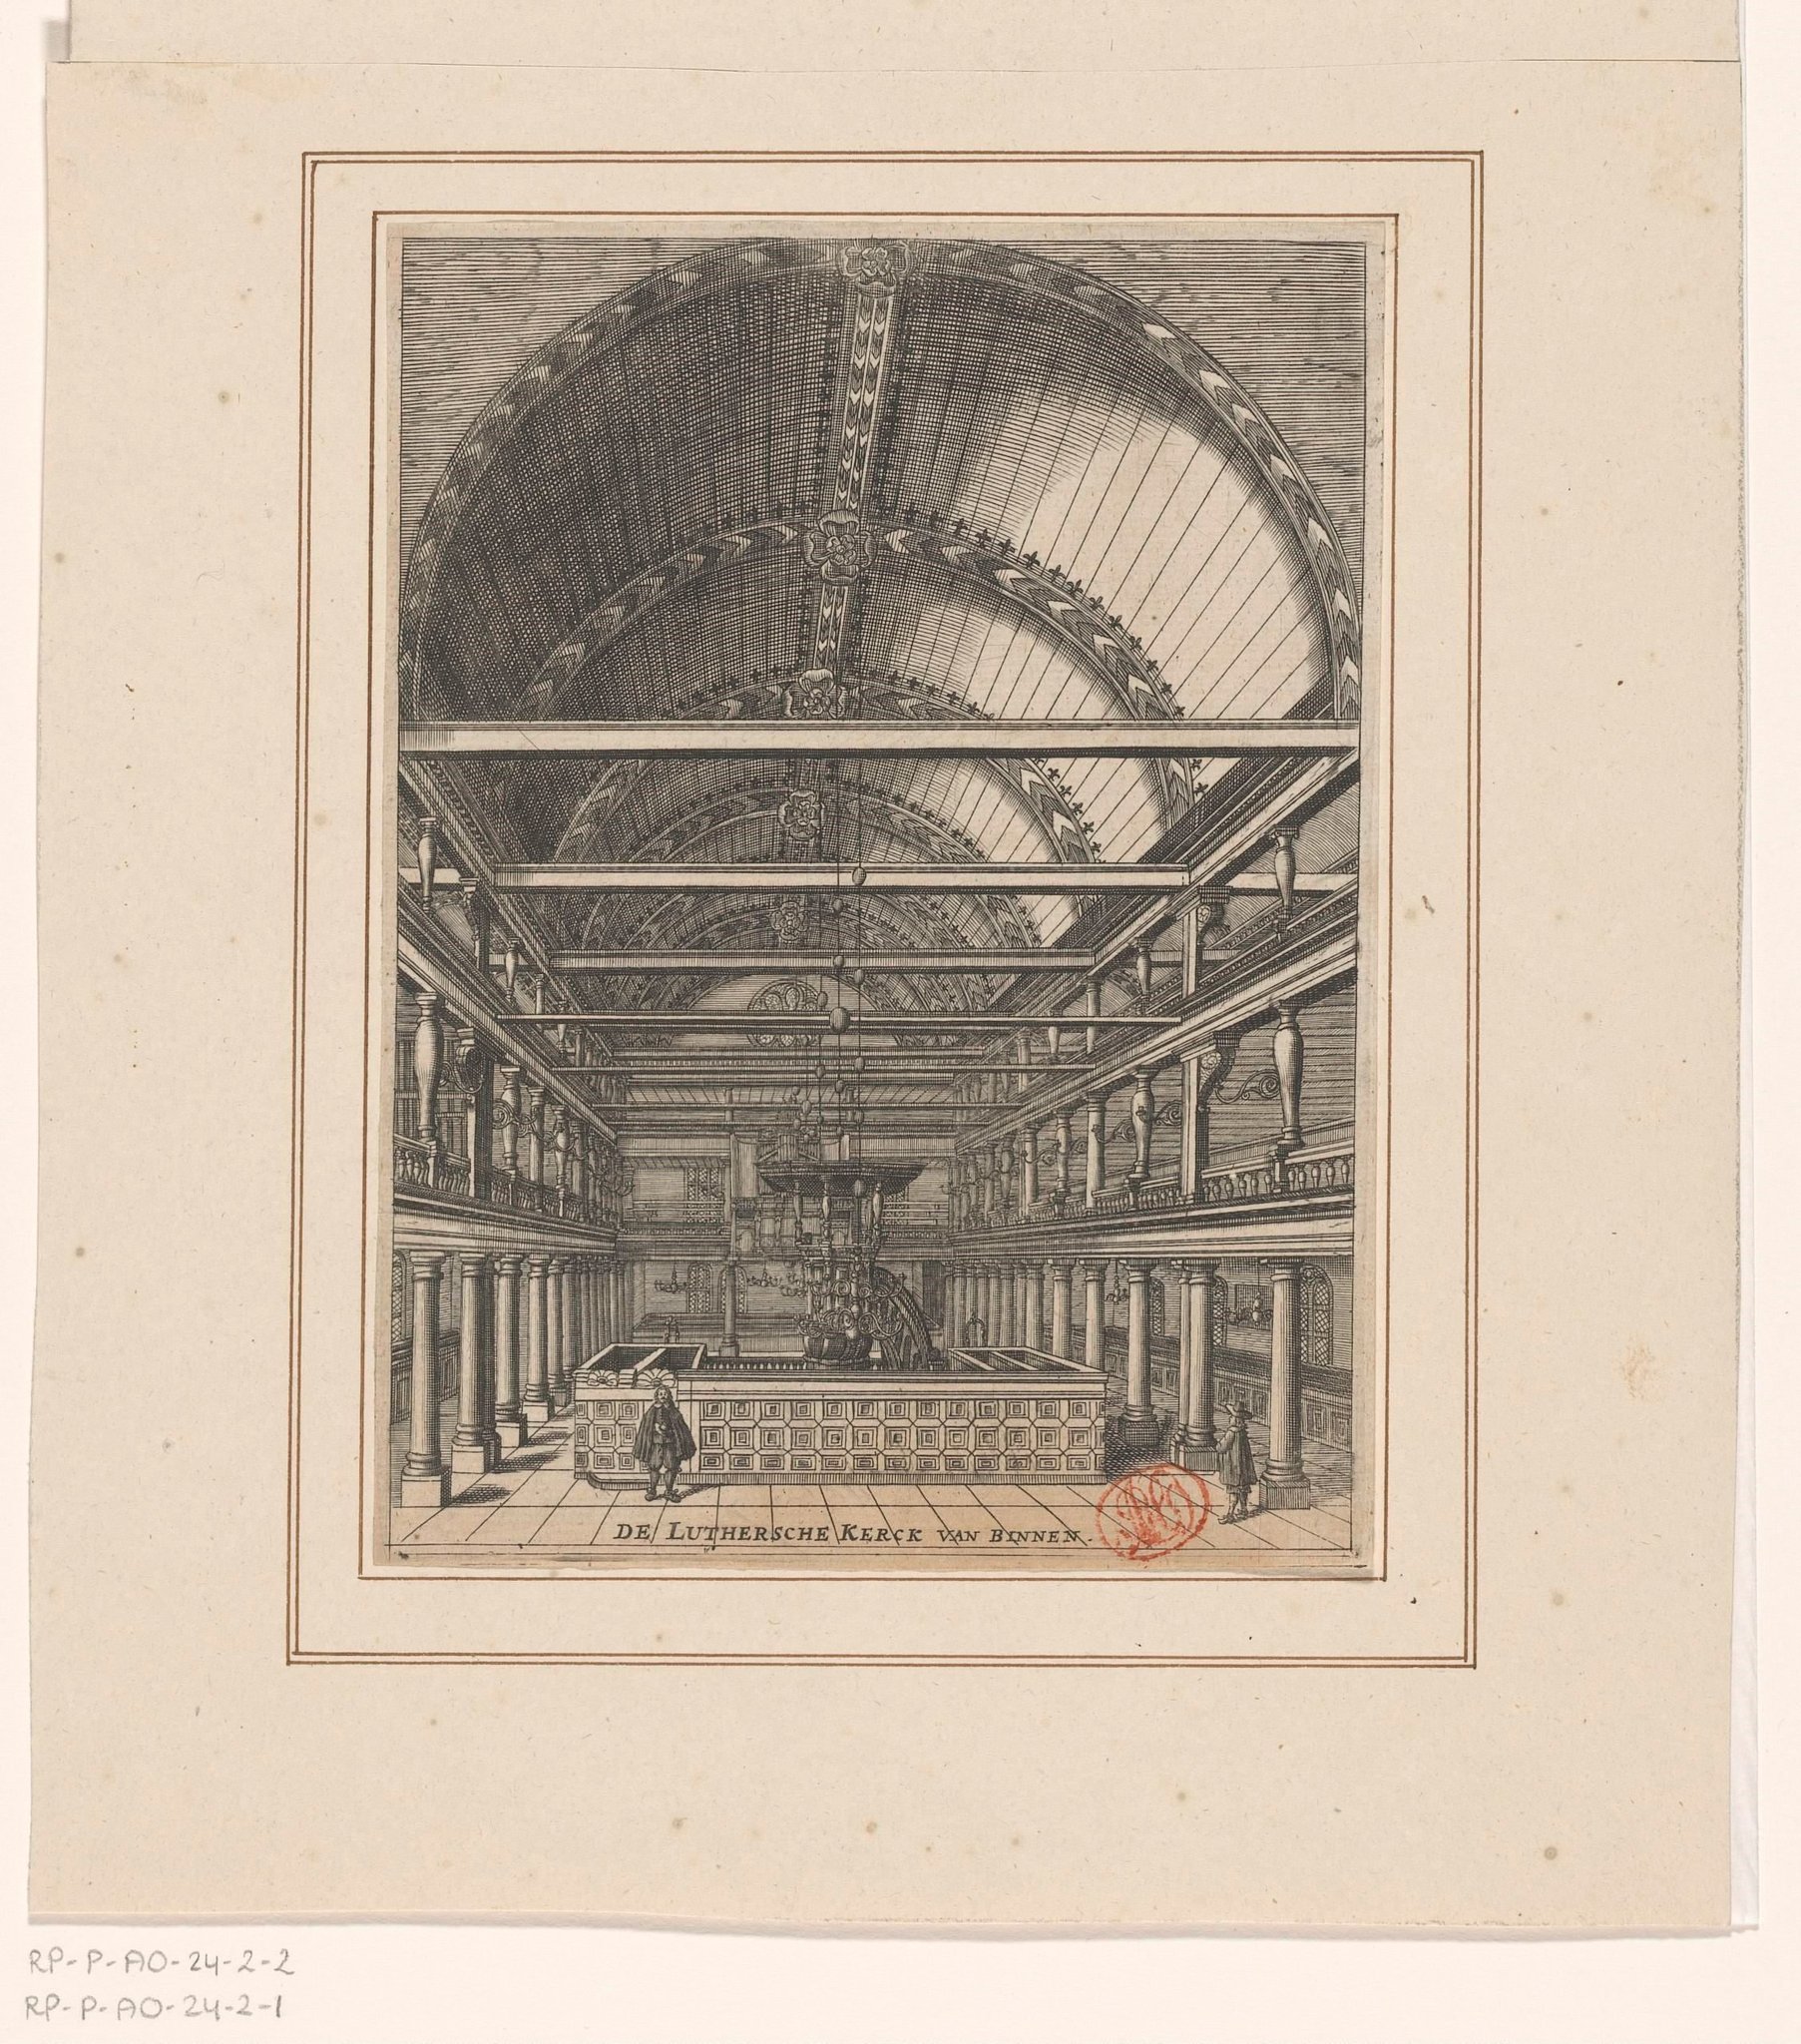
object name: book illustration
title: Interieur van de Oude Lutherse Kerk te Amsterdam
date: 1664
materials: paper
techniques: engraving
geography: amsterdam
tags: protestant churches and denominations (lutherans), interior of church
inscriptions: collector's mark: Lugt 195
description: Prent ook gebruikt in: Zesen, Philipp von. Beschreibung der Stadt Amsterdam: darinnen von derselben ersten Ursprunge bis auf gegenwärtigen Zustand (…). Amsterdam: Joachim Nosche, 1664. In tegenstelling tot de meeste andere prenten uit deze publicatie lijkt het erop dat deze prent niet ook is gebruikt in: Dapper, Olfert. Historische beschryving der stadt Amsterdam: waer in de voornaemste geschiedenissen (na een kort verhael van gansch Hollant en d'omleggende dorpen (…). Amsterdam: Jacob van Meurs, 1663.